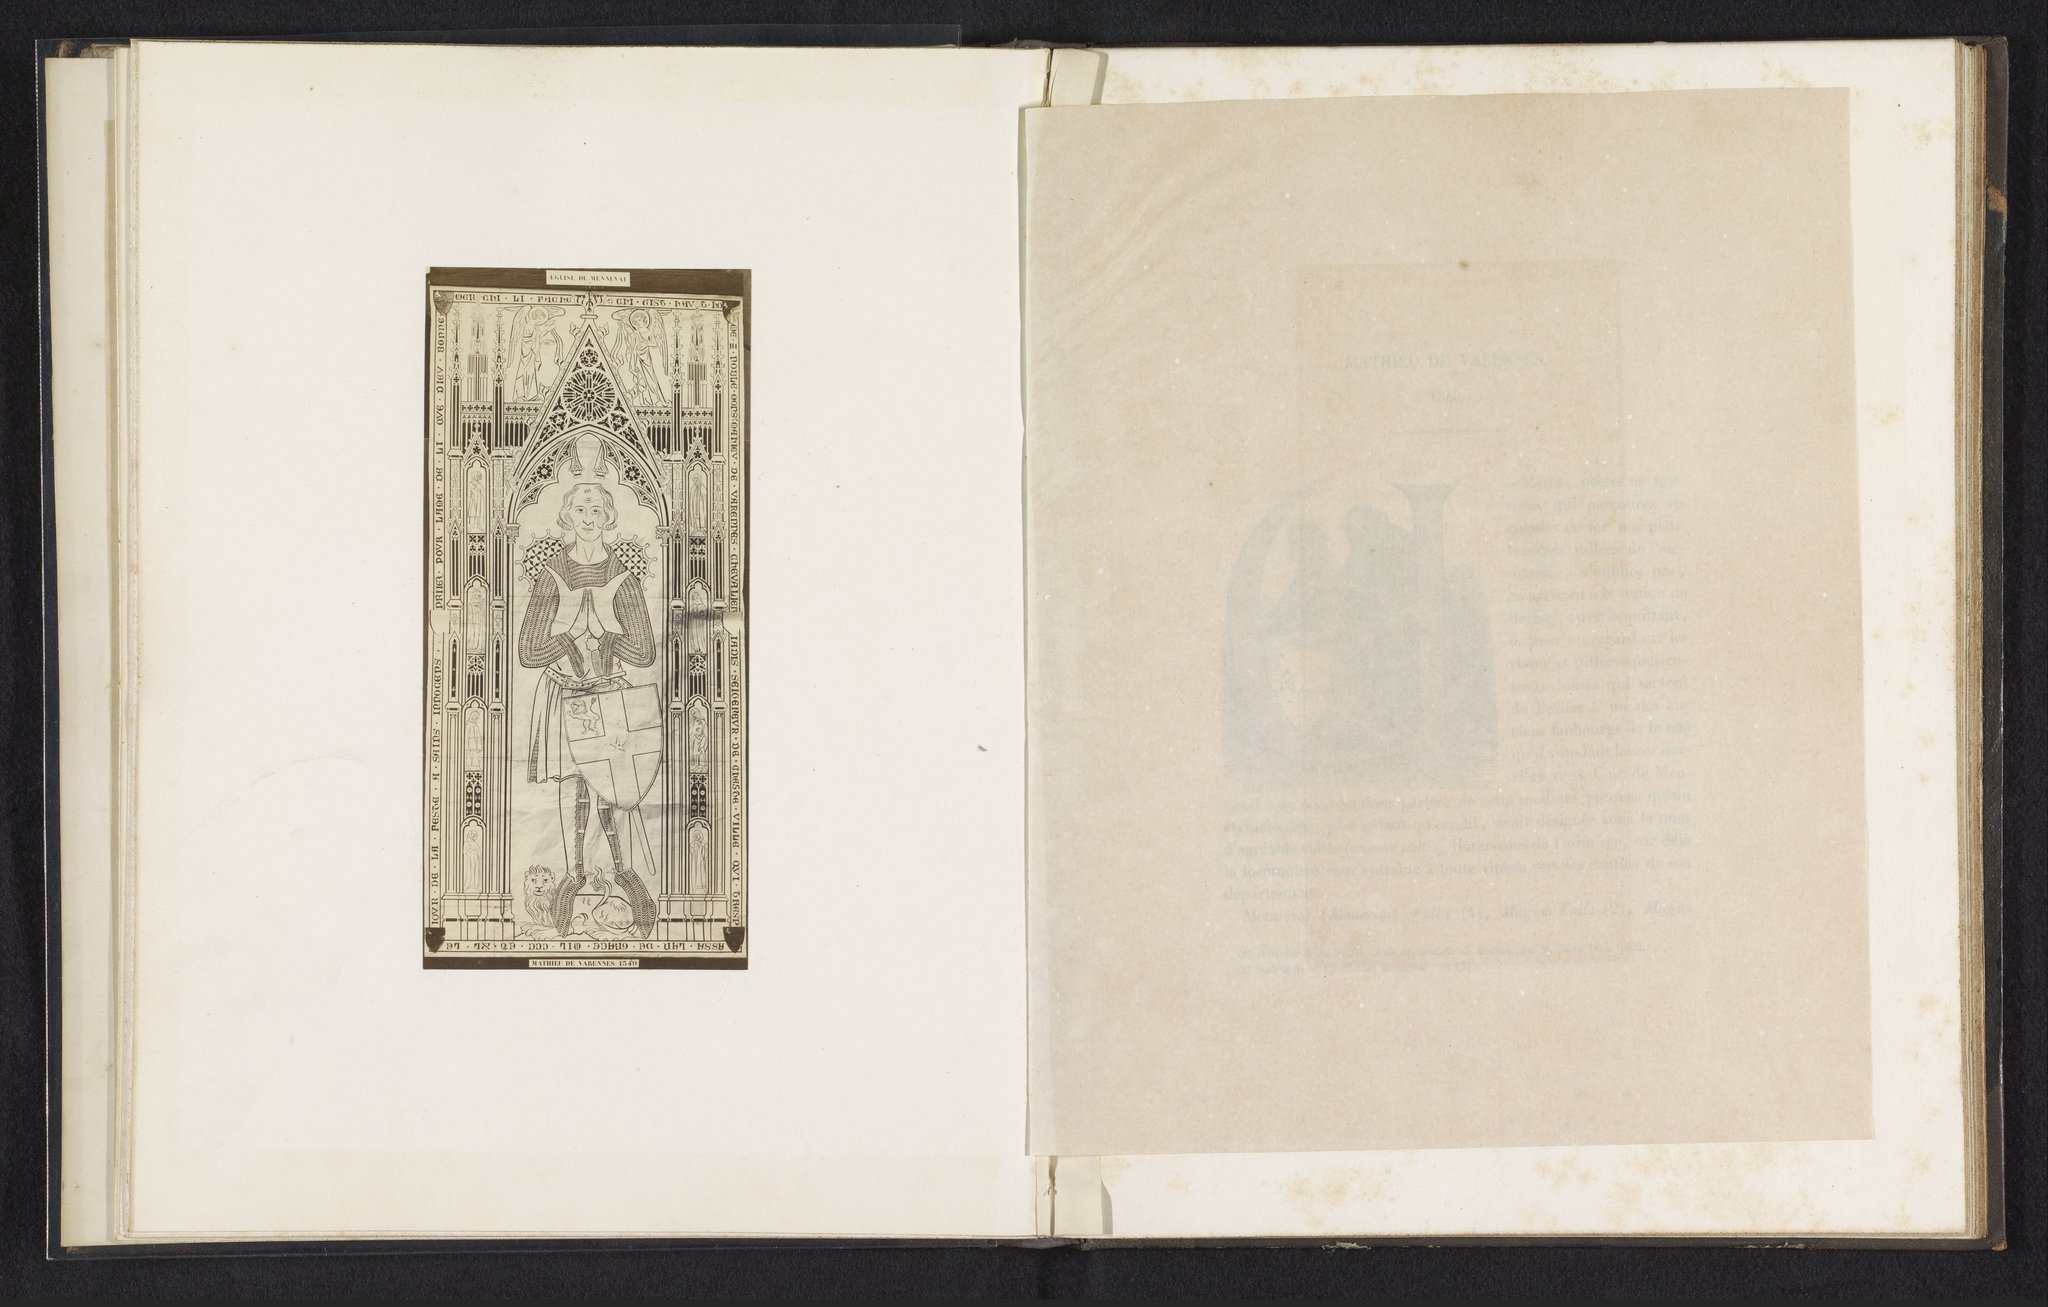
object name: reproduction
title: Fotoreproductie van een stempel naar een grafsteen van Mathieu de Varennes in een kerk in Menneval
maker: Anonymous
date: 1851-1861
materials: photographic support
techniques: albumen print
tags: gravestone, tombstone